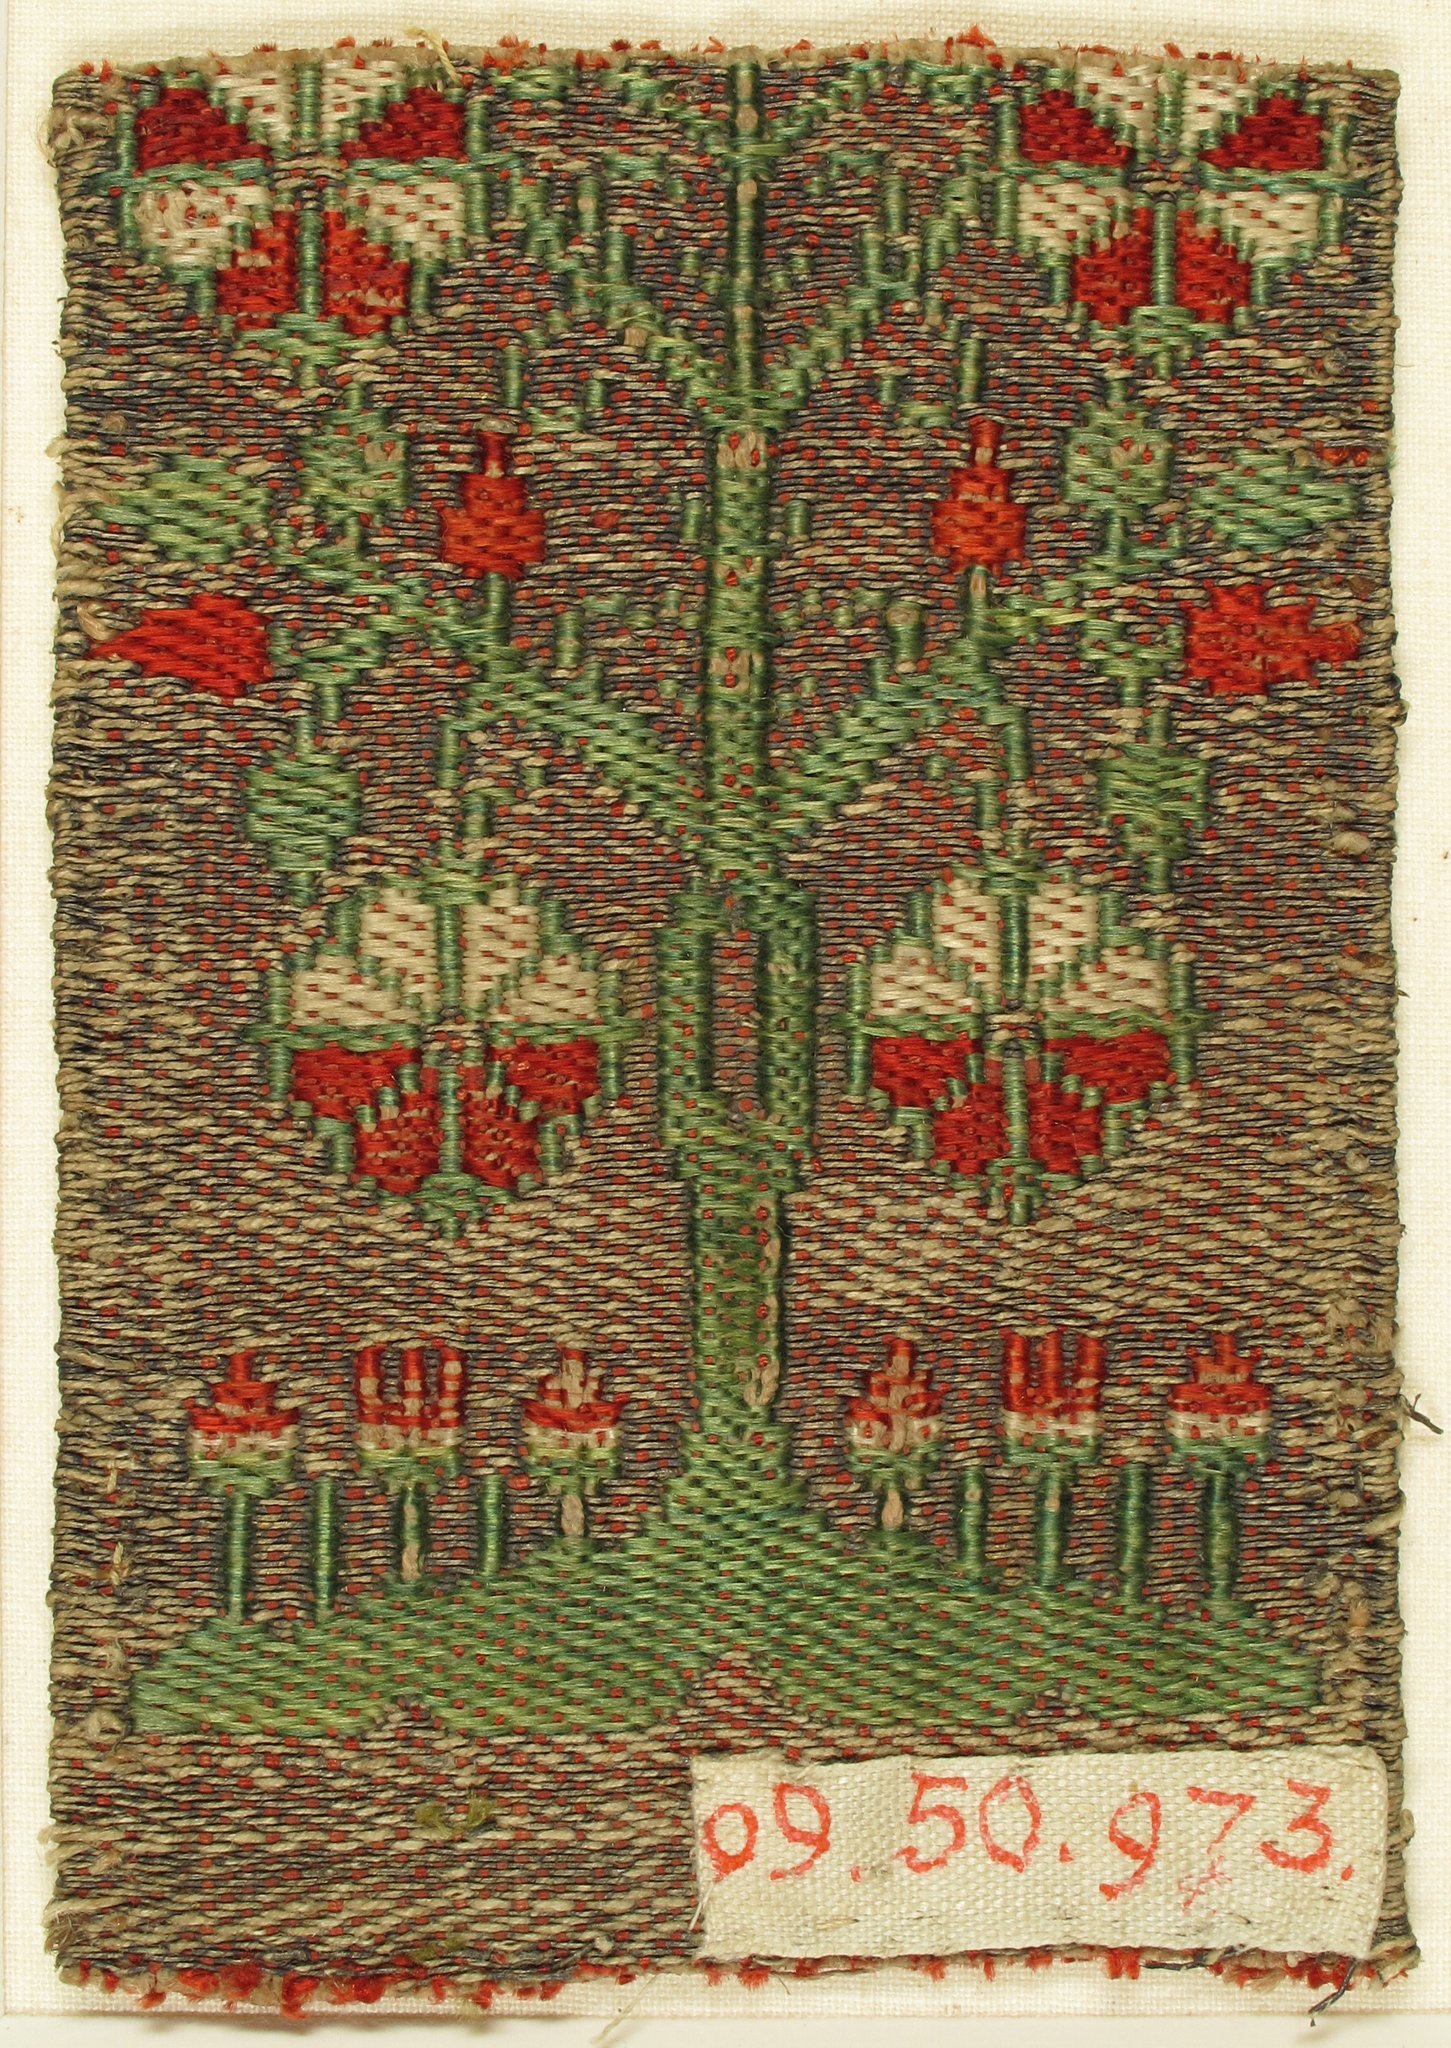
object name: textile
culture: german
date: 1401-1500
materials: linen, metal thread, silk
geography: germany